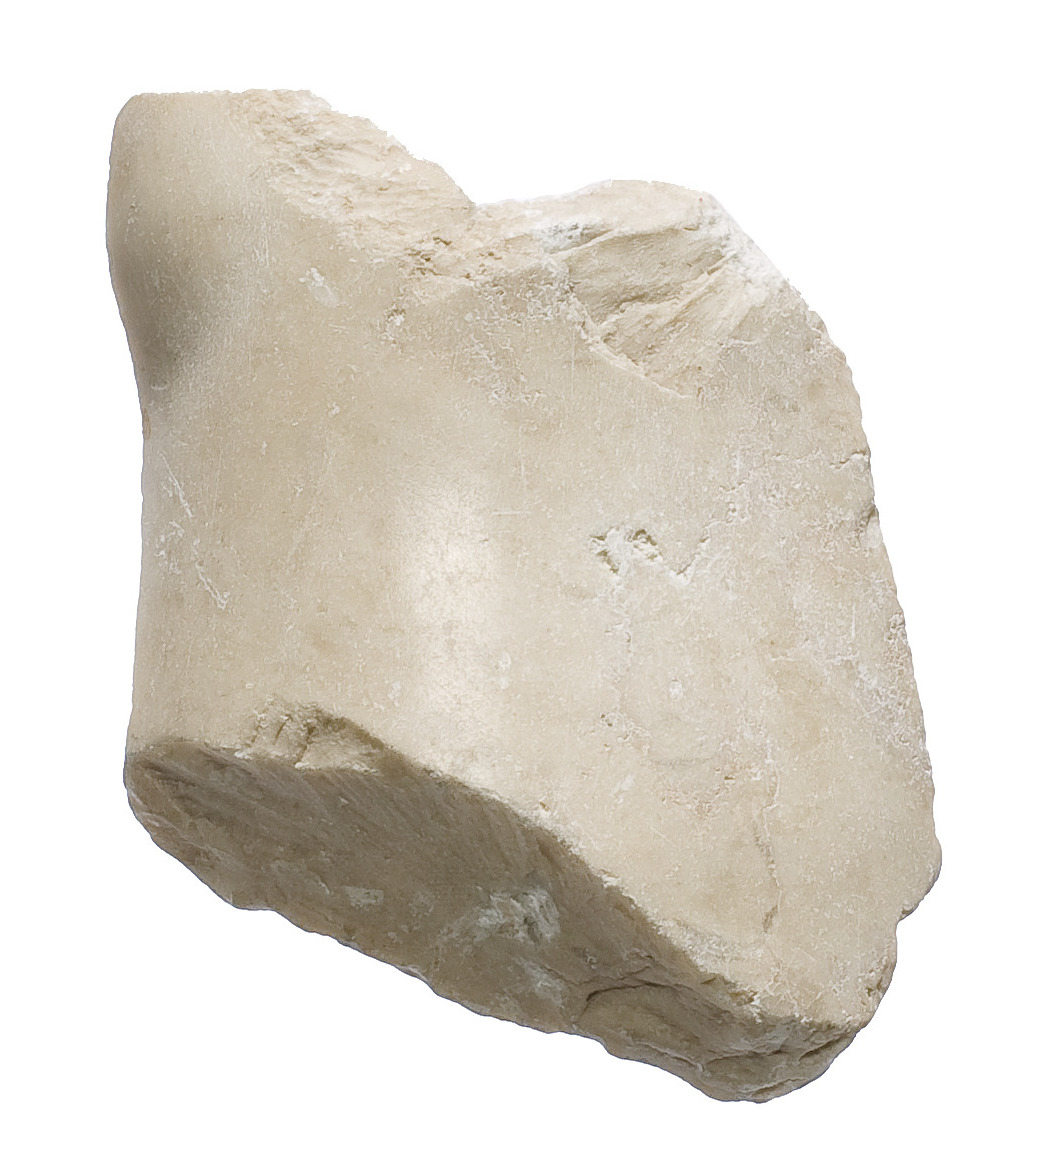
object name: knee, male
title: Knee fragment, probably male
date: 1353-1336 BCE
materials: limestone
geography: egypt